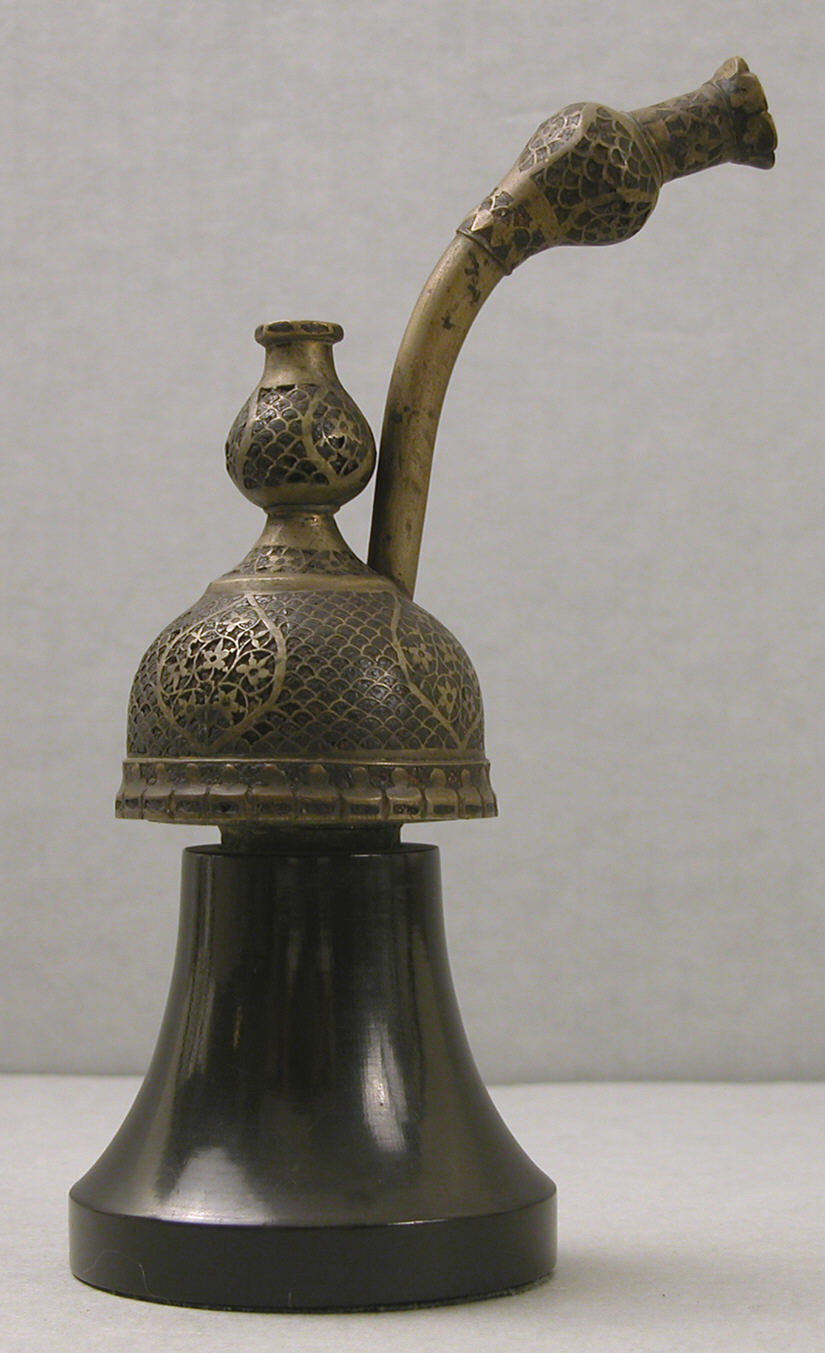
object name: water pipe top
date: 1801-1900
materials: alloy, brass, zinc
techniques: casting, engraving, inlay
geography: india